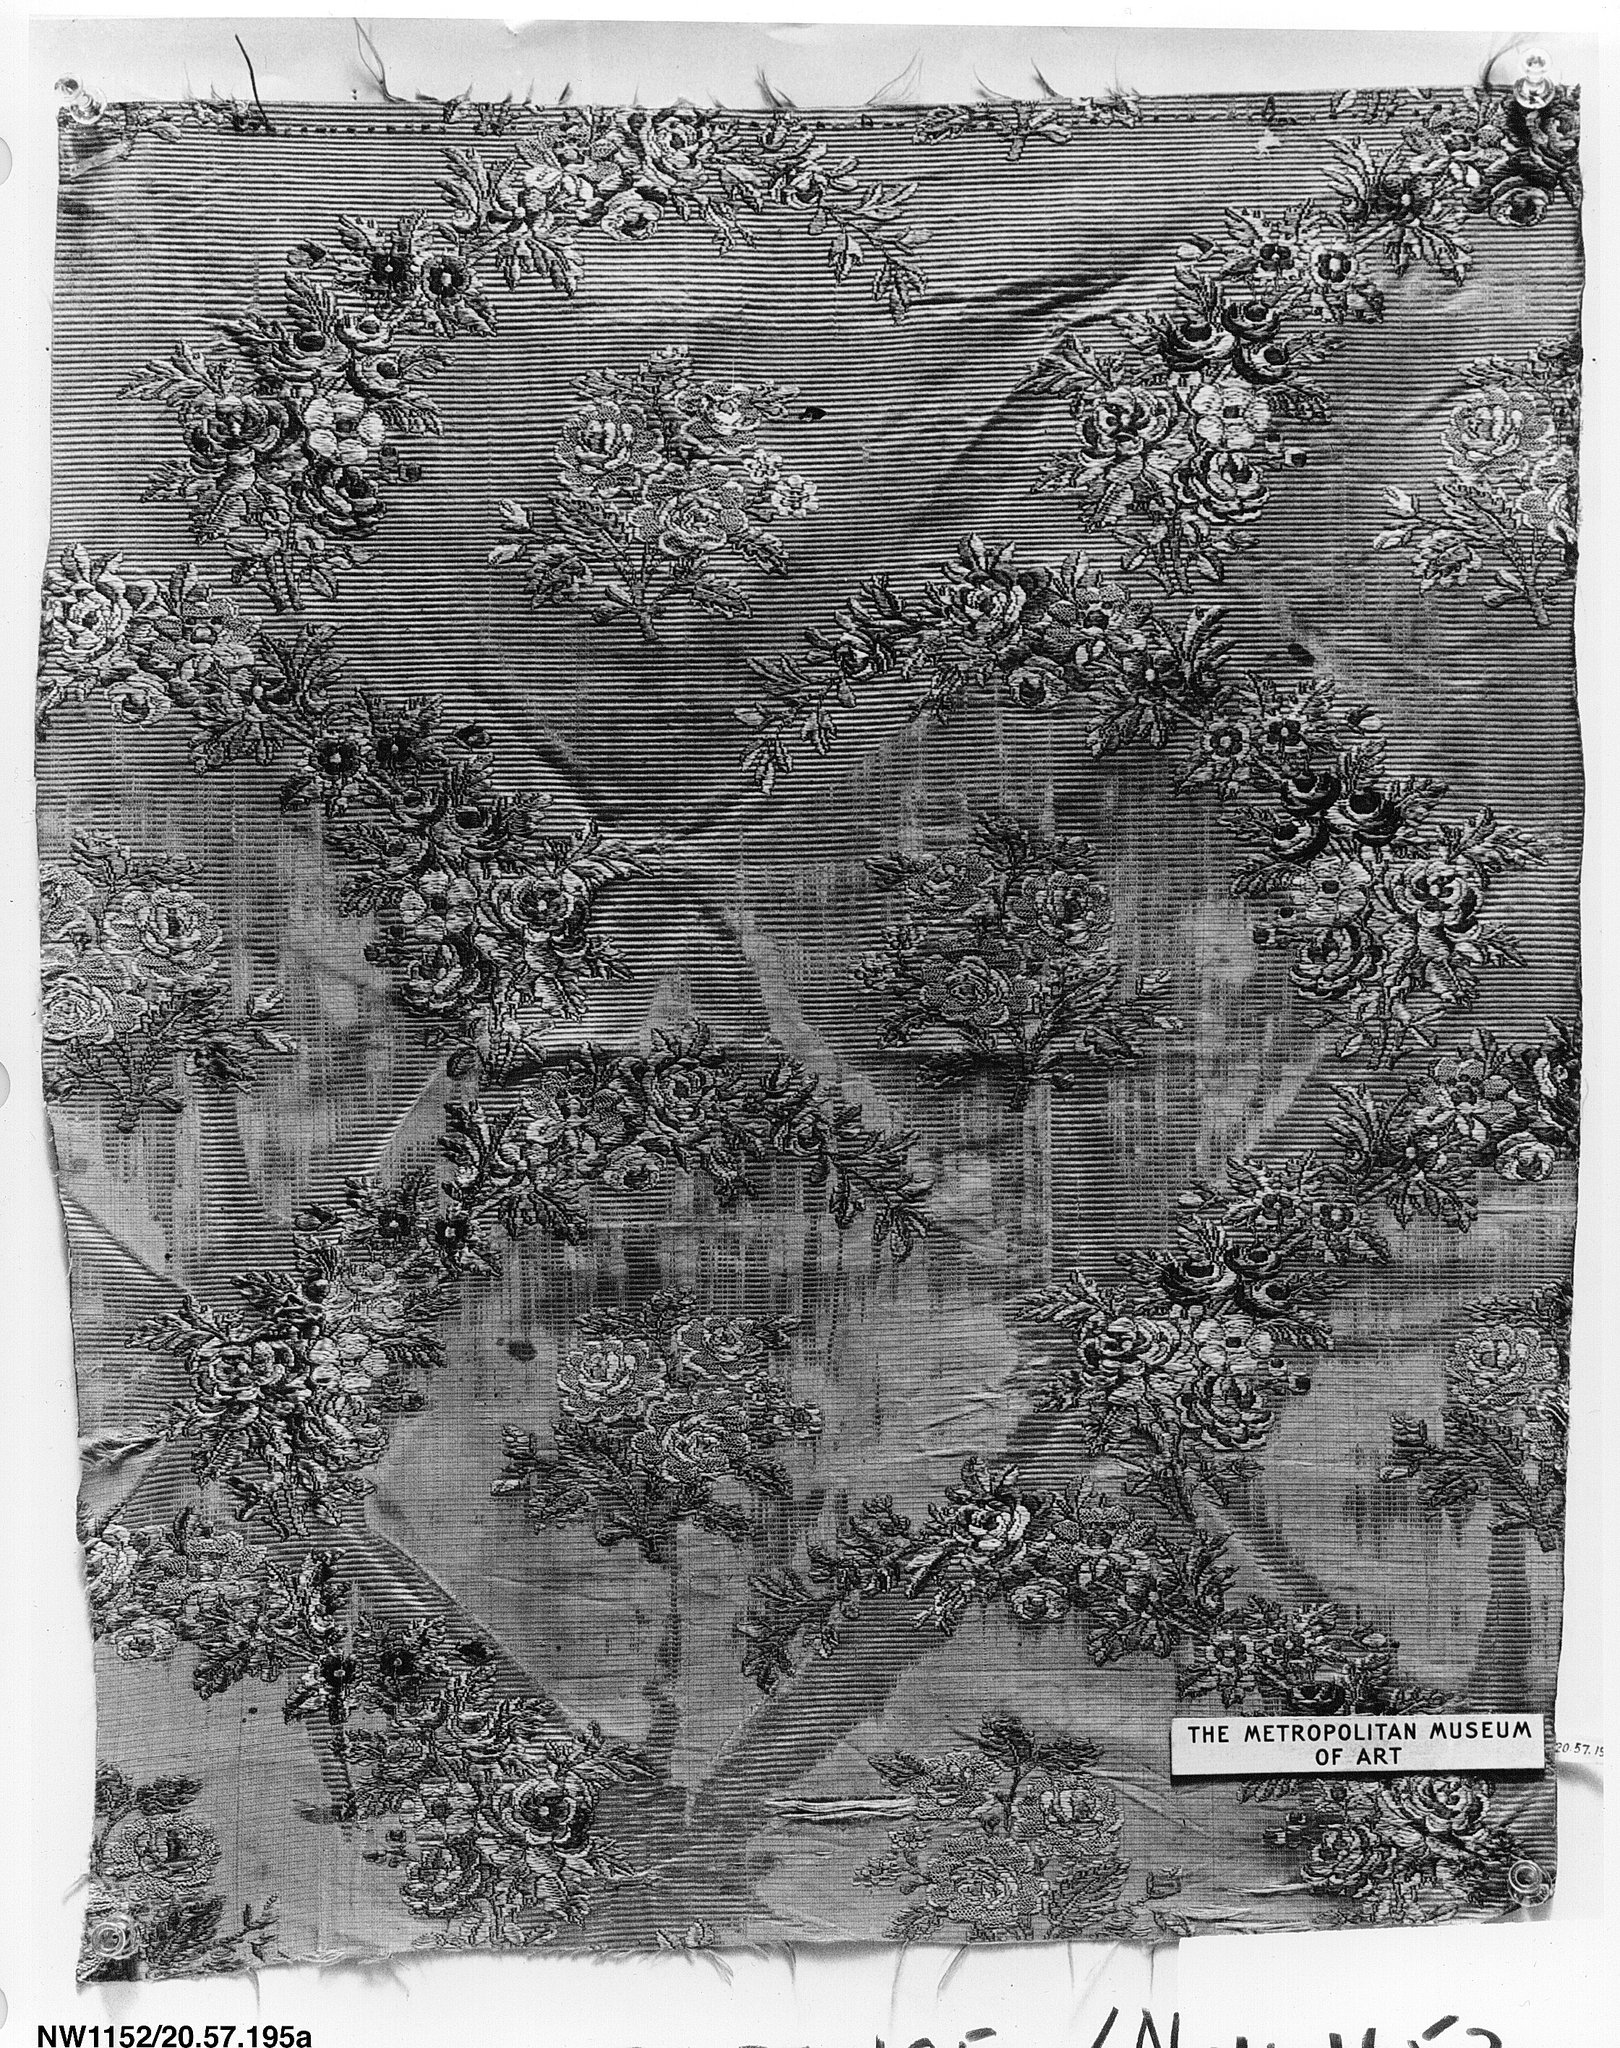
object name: piece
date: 1760-1770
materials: silk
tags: flowers,leaves